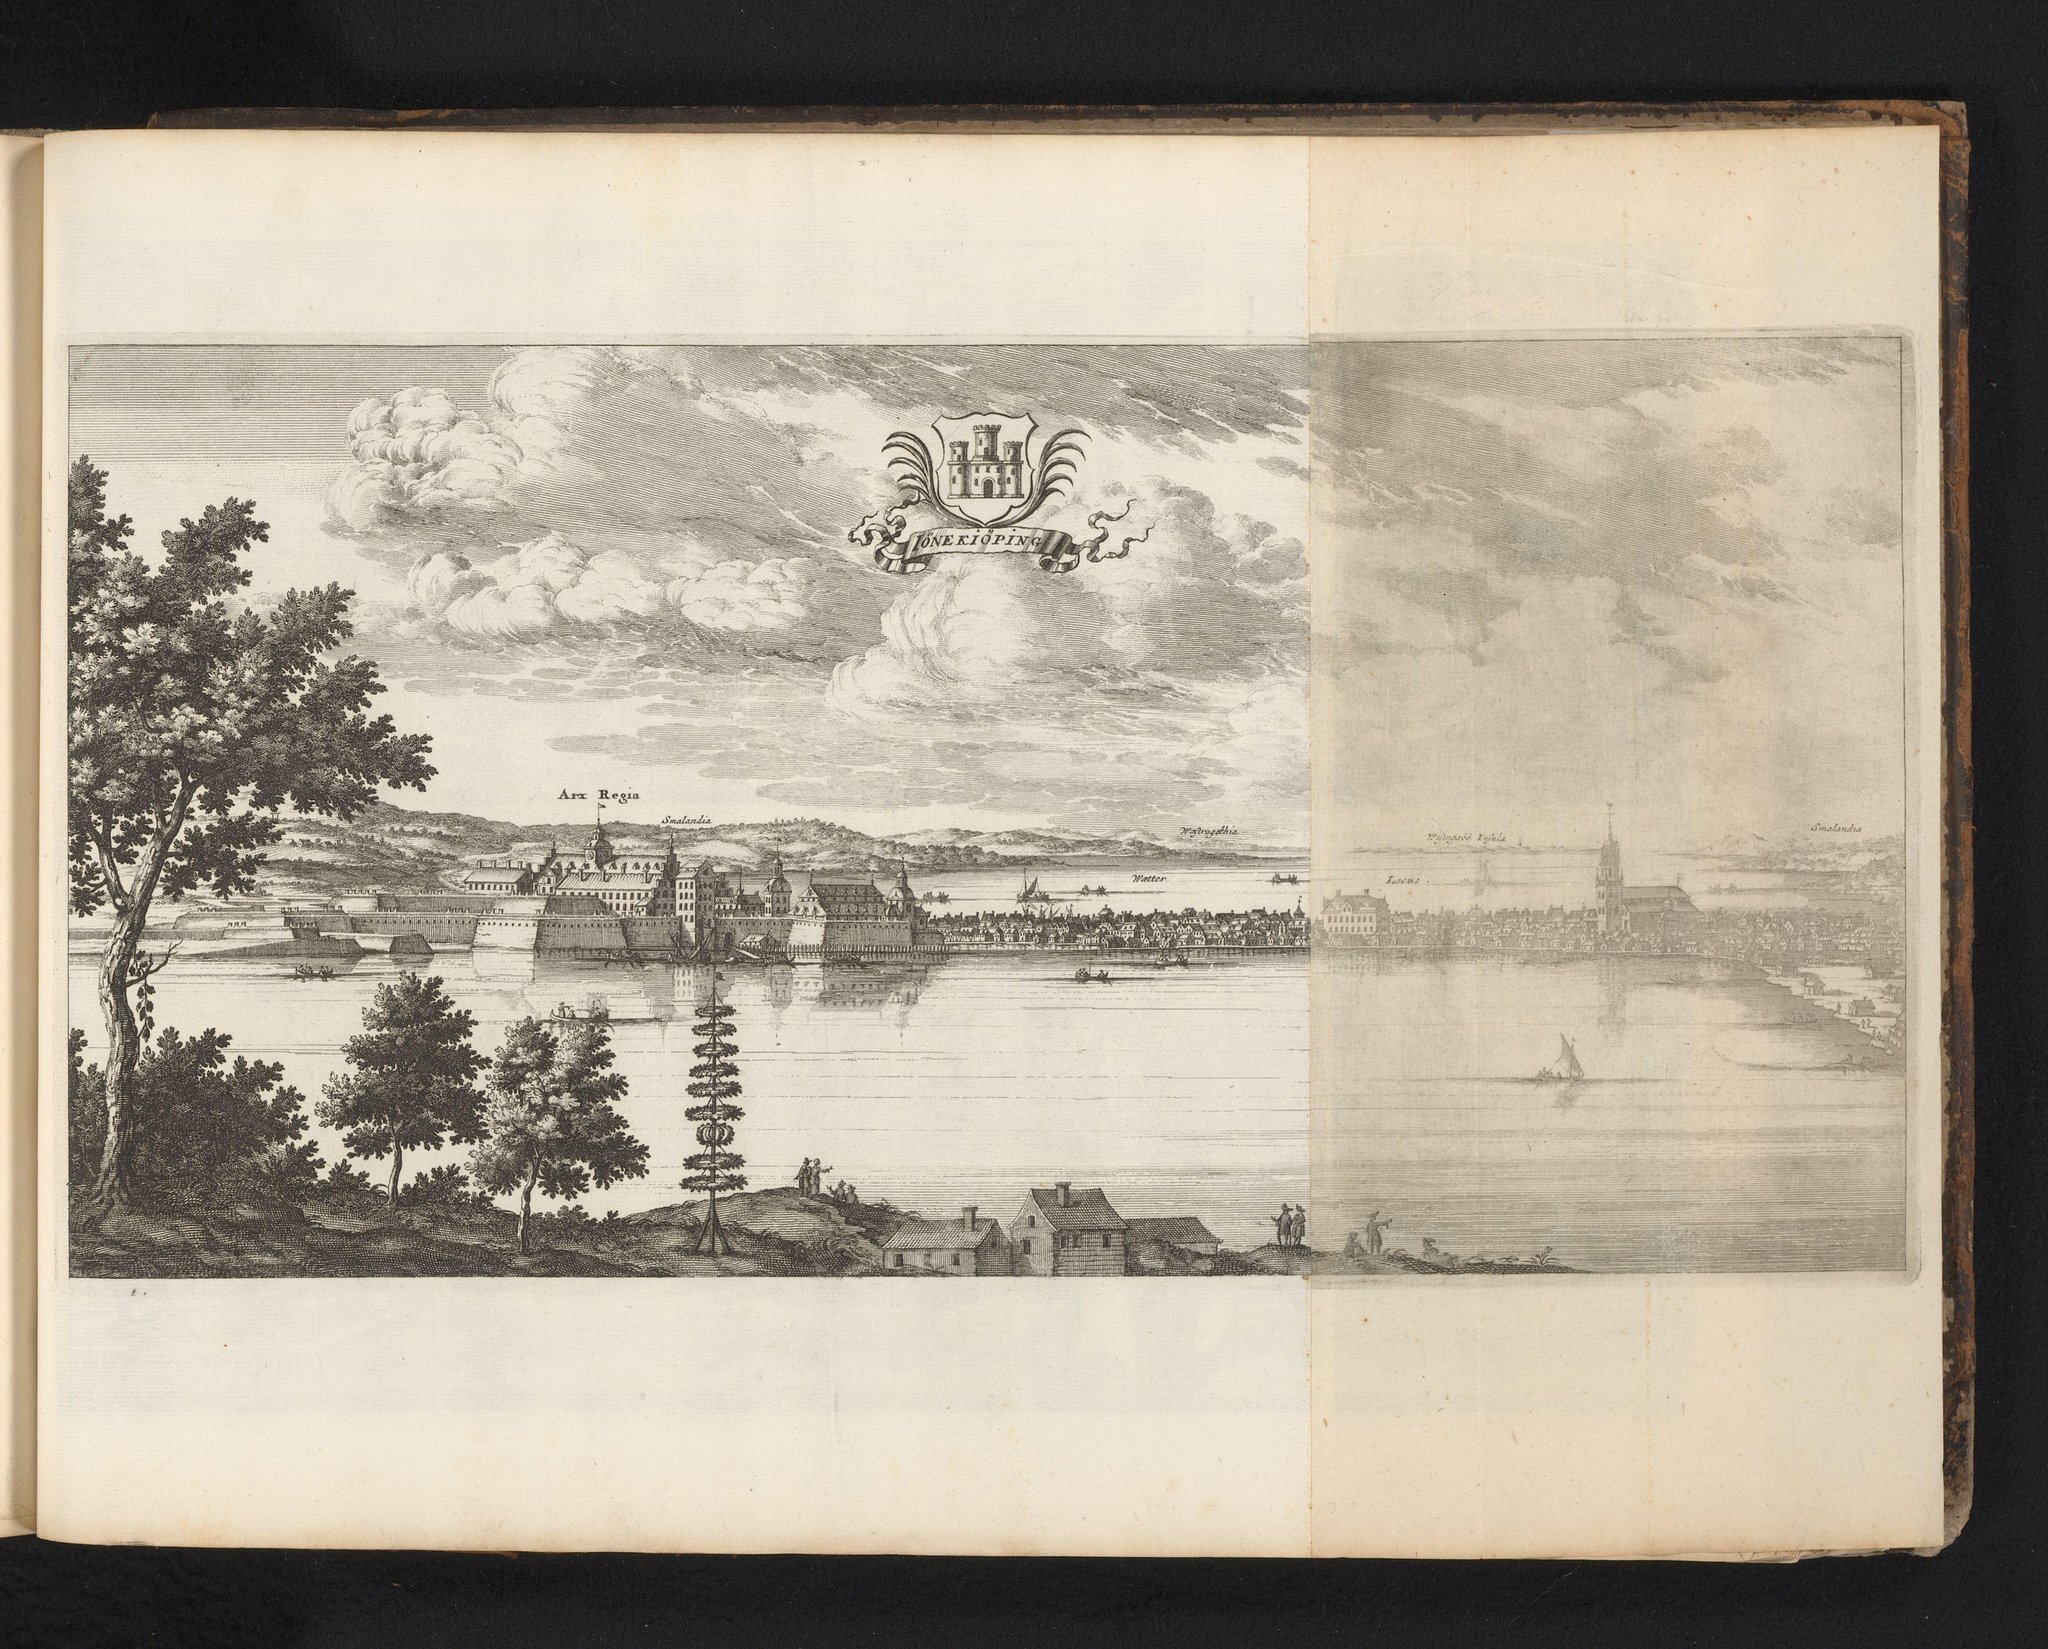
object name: album leaf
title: Jönekiöping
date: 1693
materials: paper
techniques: etching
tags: city-view in general; 'veduta'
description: Kungliga Biblioteket, 'Suecia': http://www.kb.se/samlingarna/Kartor-bilder/Suecia-antiqua/ (geraadpleegd november 2016).